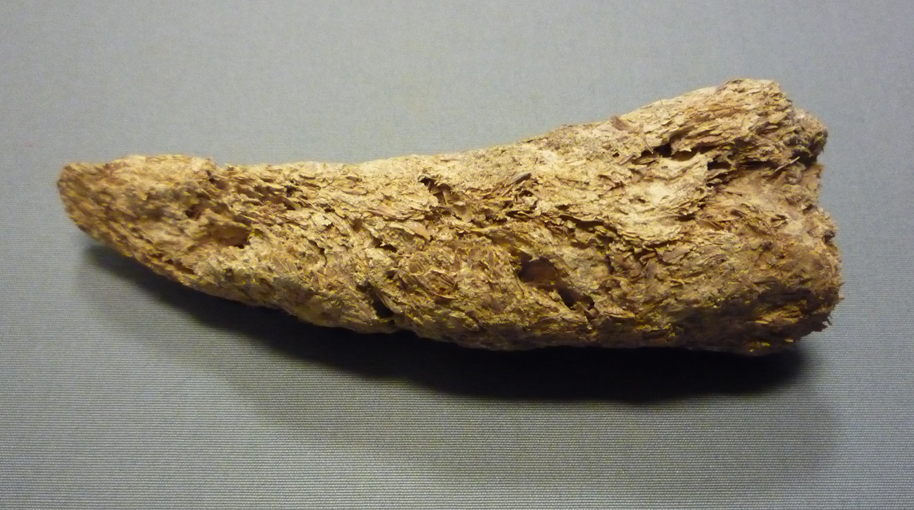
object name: food, bread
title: Conical Loaf of Bread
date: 1479-1458 BCE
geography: egypt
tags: bread